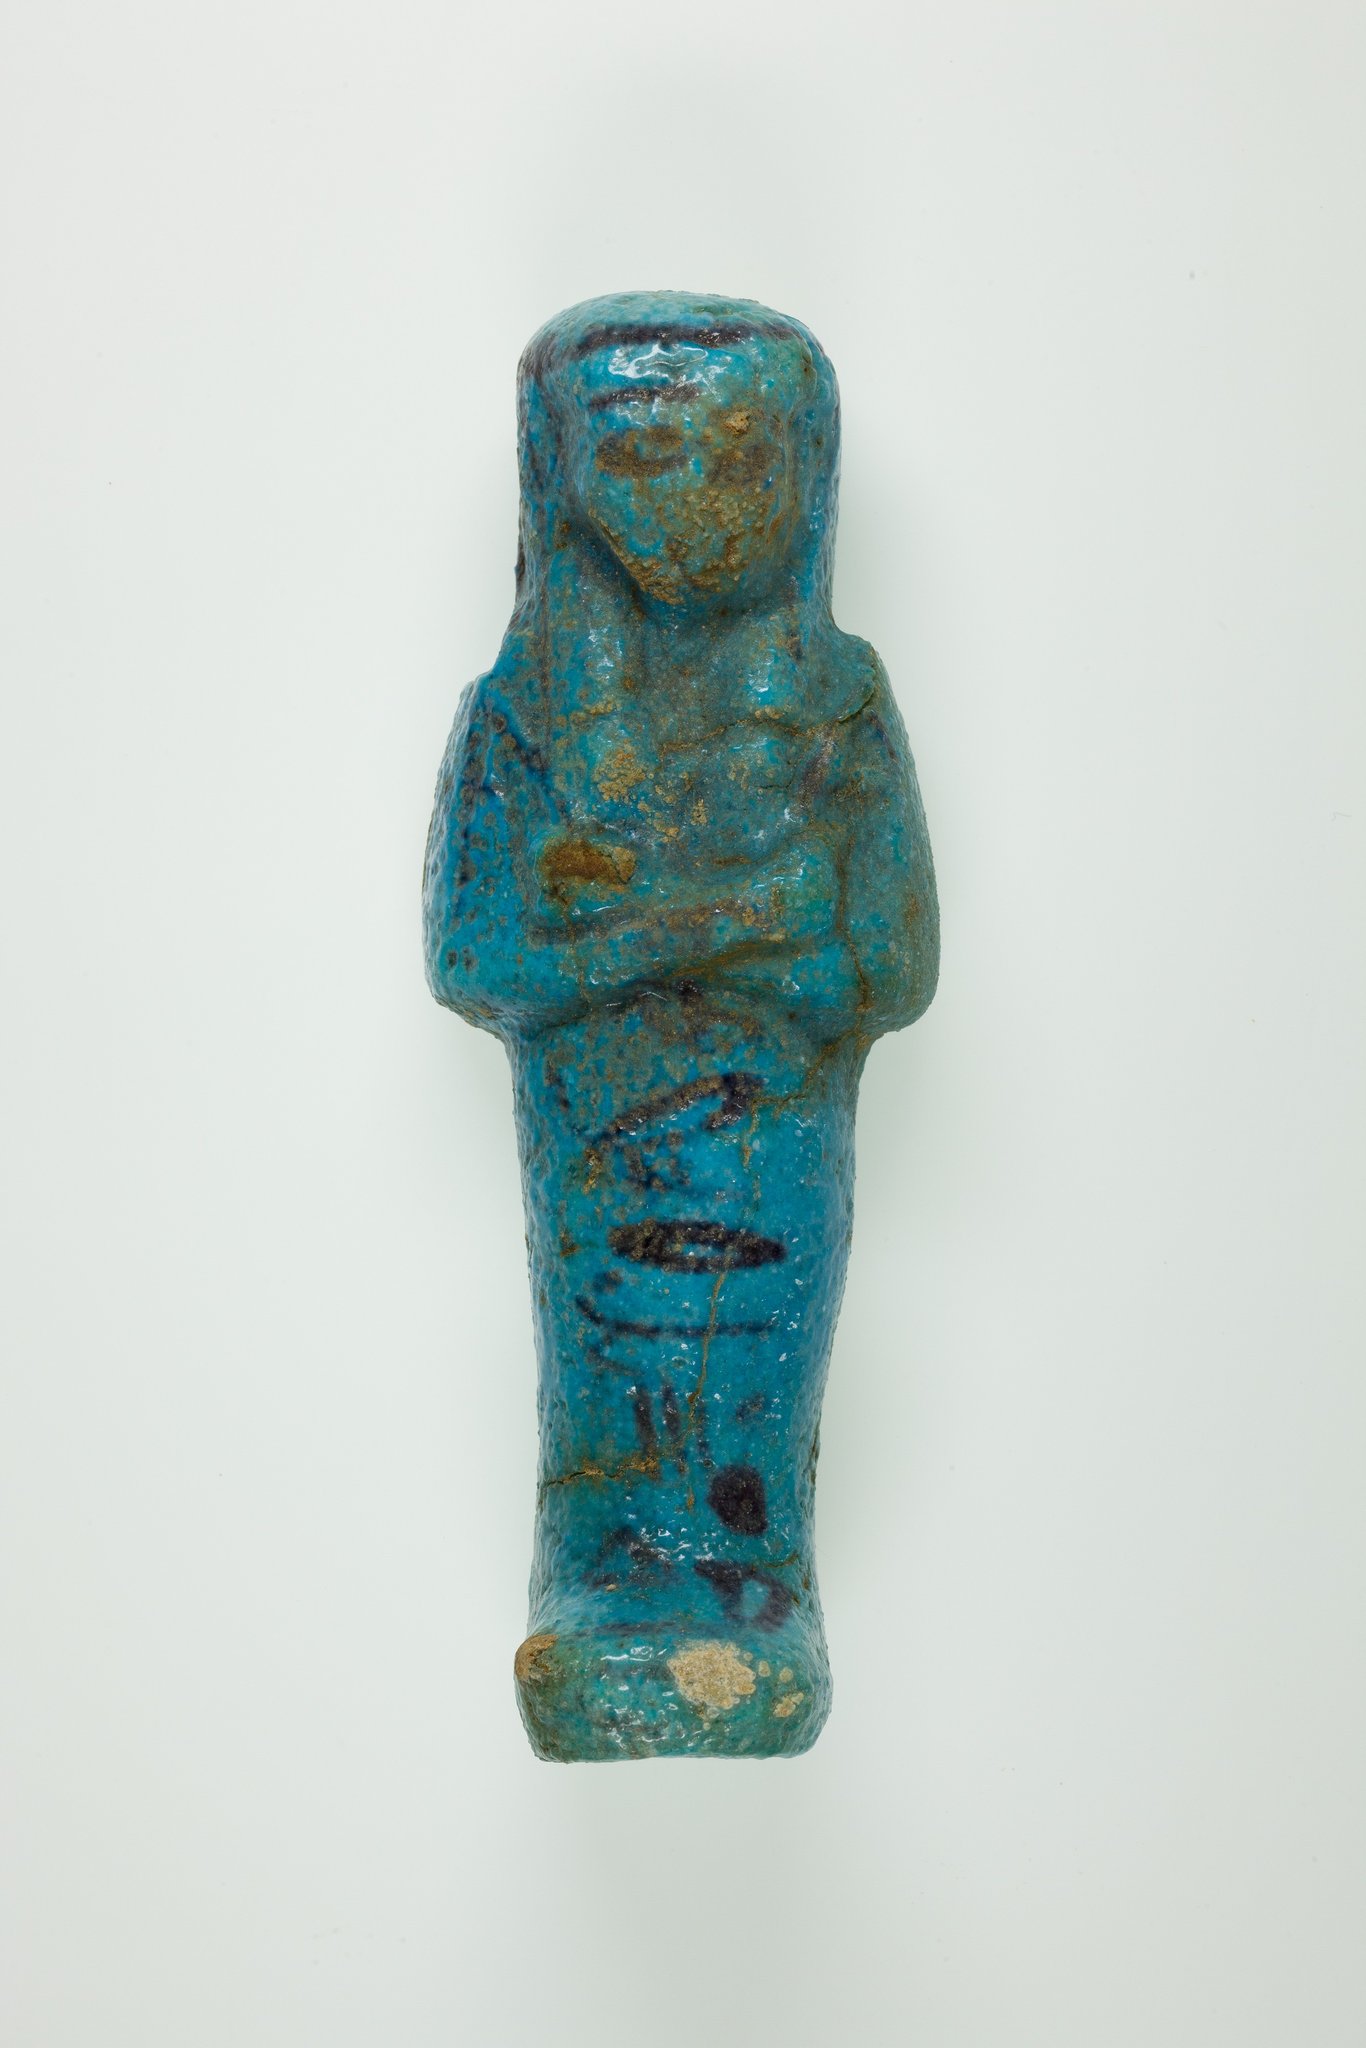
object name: worker shabti, henettawy c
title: Worker Shabti of Henettawy (C), Daughter of Isetemkheb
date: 990-970 BCE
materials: faience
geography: egypt